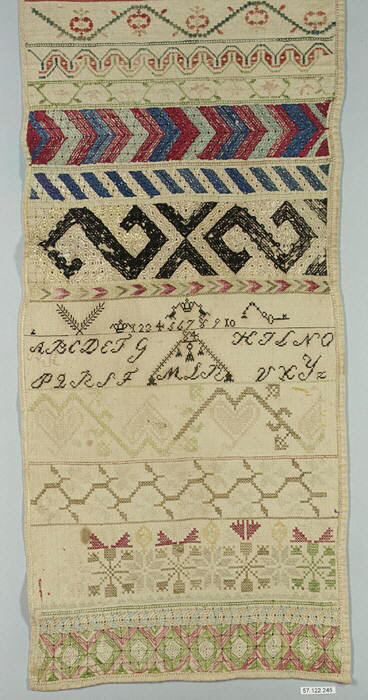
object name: sampler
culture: mexican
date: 1801-1900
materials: cotton, silk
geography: mexico